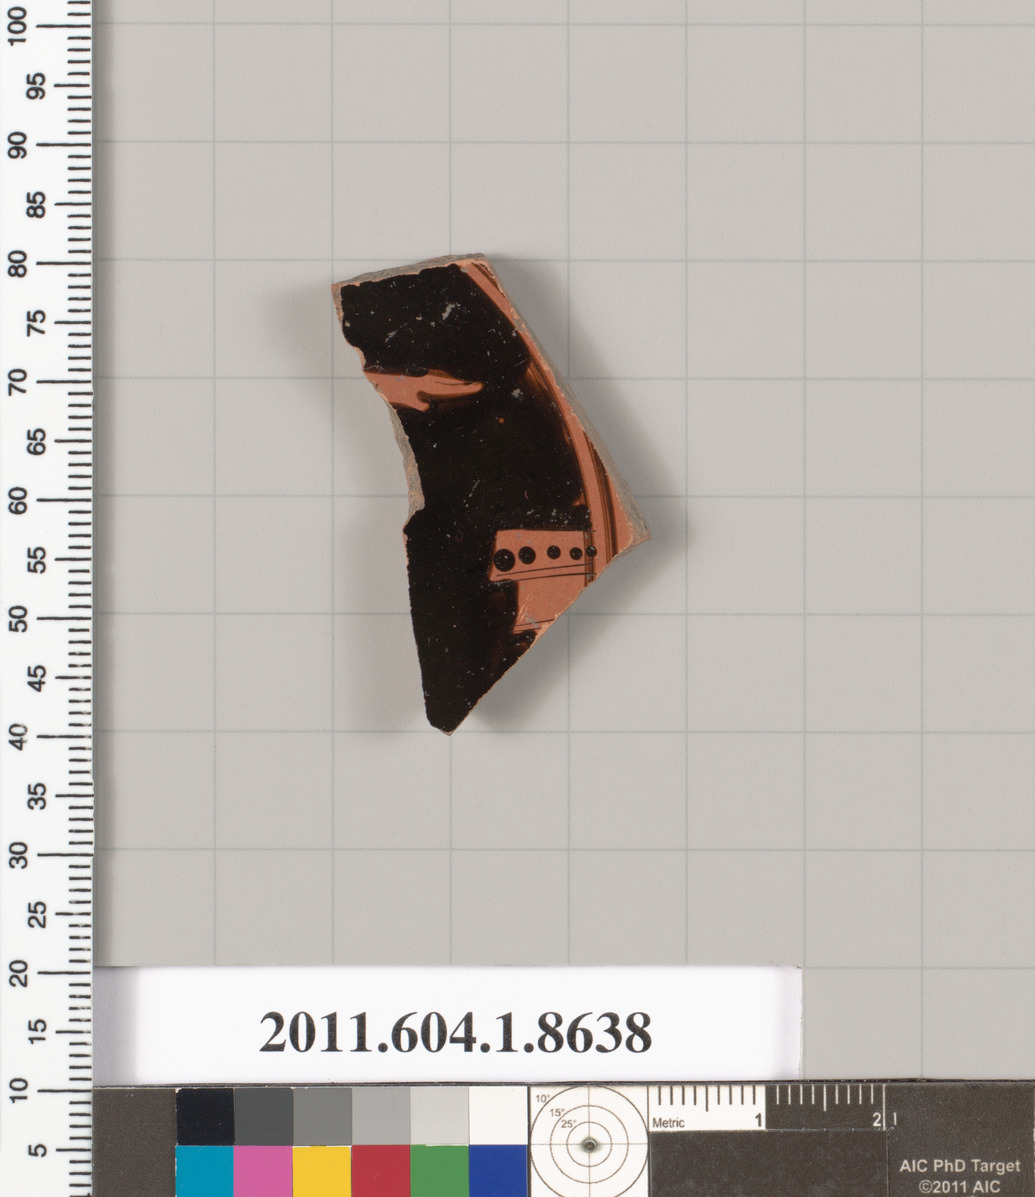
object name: kylix fragment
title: Terracotta fragment of a stemless kylix (drinking cup)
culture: greek, attic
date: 467-435 BCE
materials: terracotta